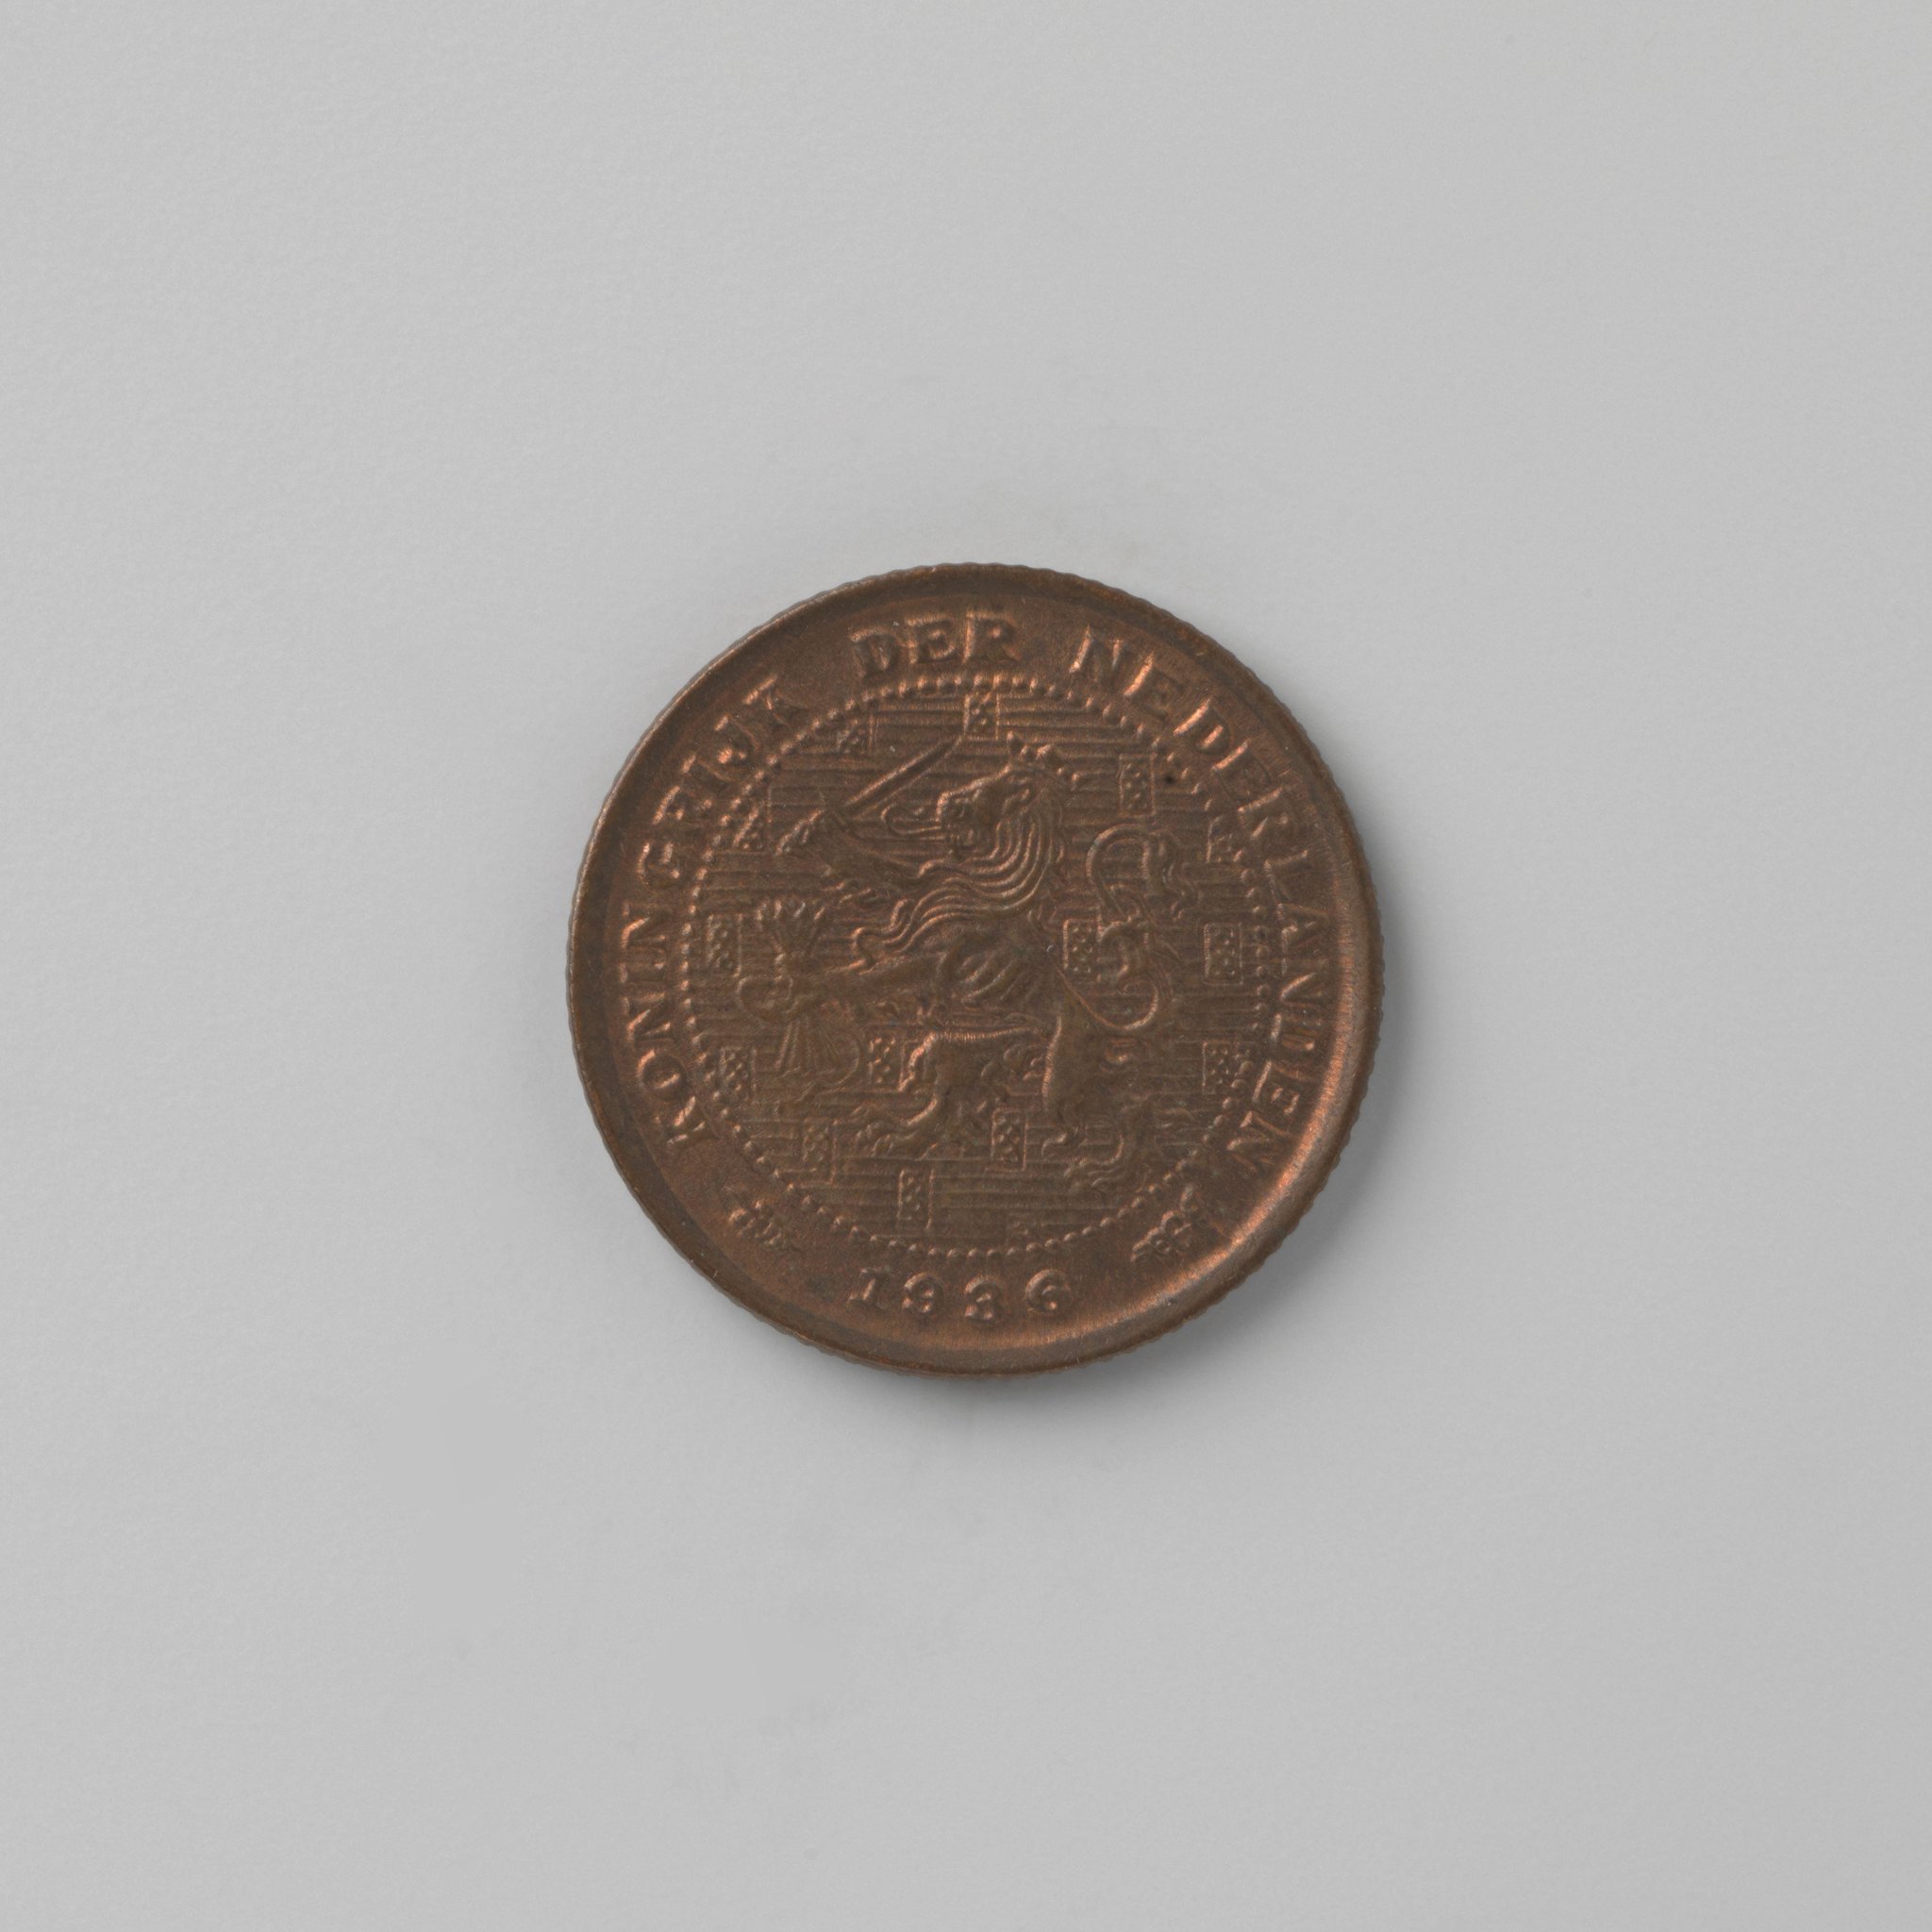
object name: coin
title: Nederlandse ½ cent,1936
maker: wilhelmina of the netherlands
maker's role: print maker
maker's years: 1880-1962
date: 1936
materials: bronze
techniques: striking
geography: utrecht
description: Bronzen munt. Voorzijde: in een veld rijkswapen. Jaartal onderaan in omschrift. Keerzijde: binnen twee samengebonden oranjetakken waarde-aanduiding ½ cent. Kartelrand.